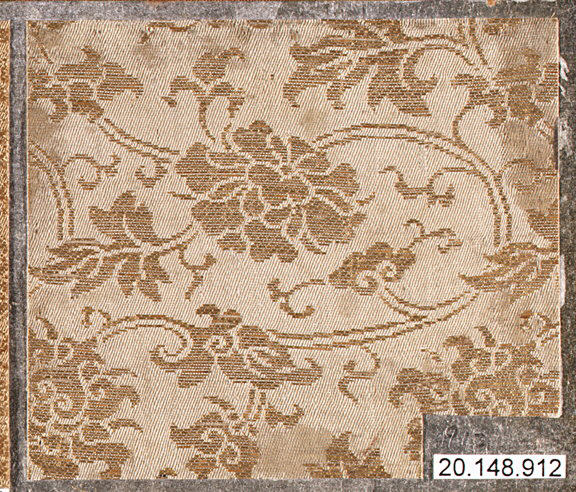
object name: piece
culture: japanese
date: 1701-1800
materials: silk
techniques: compound weave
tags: flowers,leaves